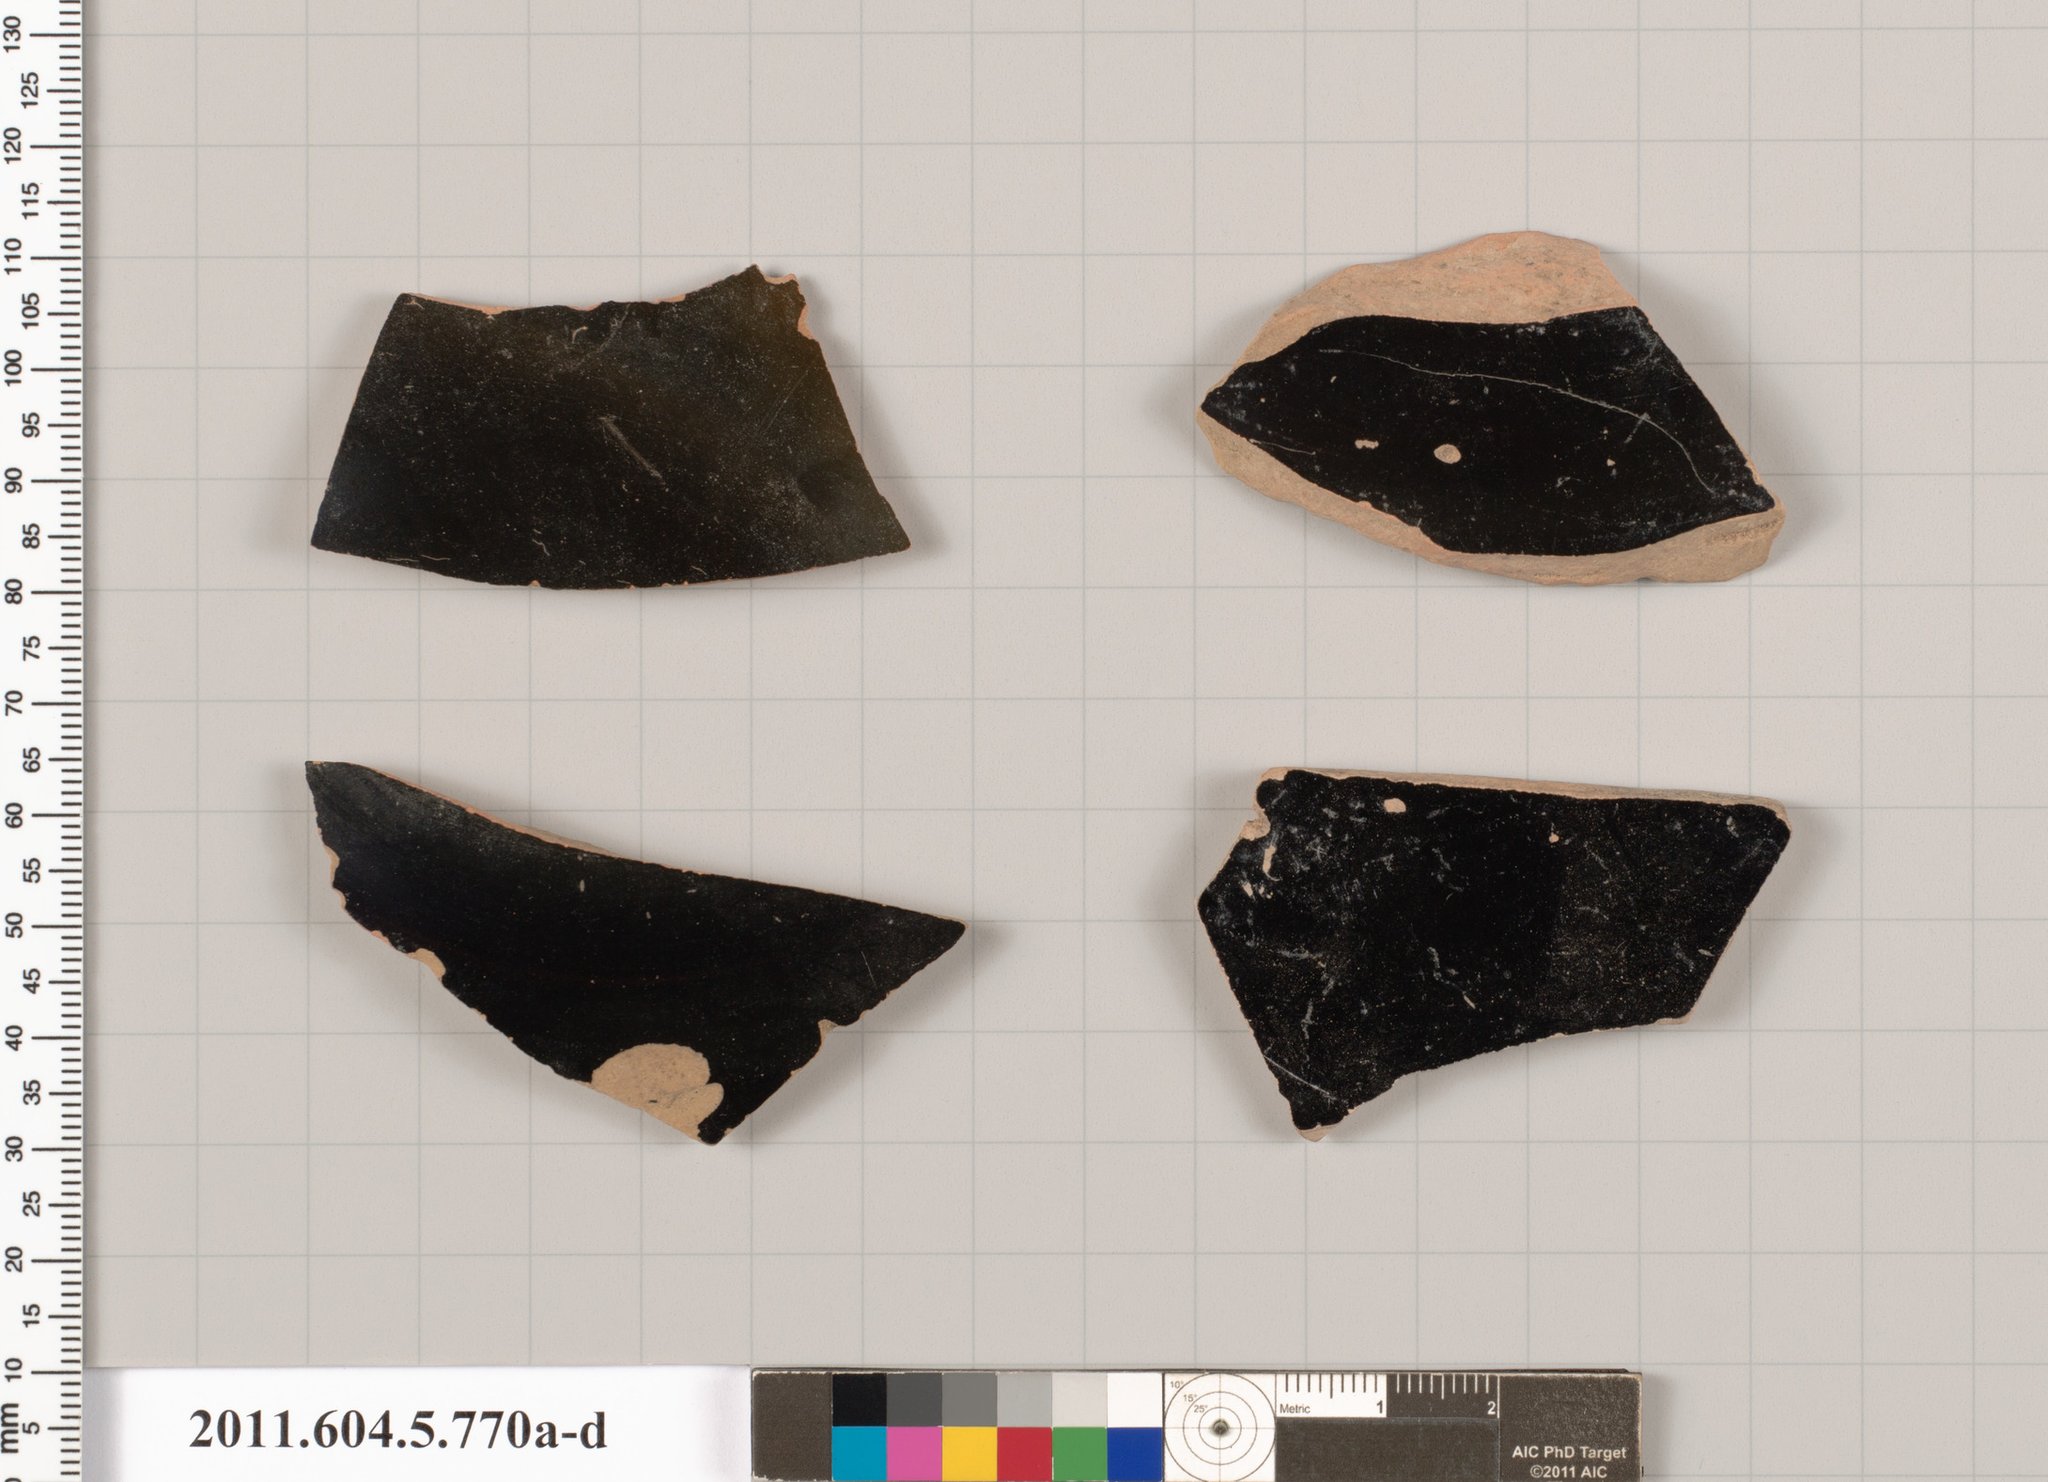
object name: kylix fragment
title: Terracotta fragments of kylikes (drinking cups)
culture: greek, attic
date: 600-401 BCE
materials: terracotta